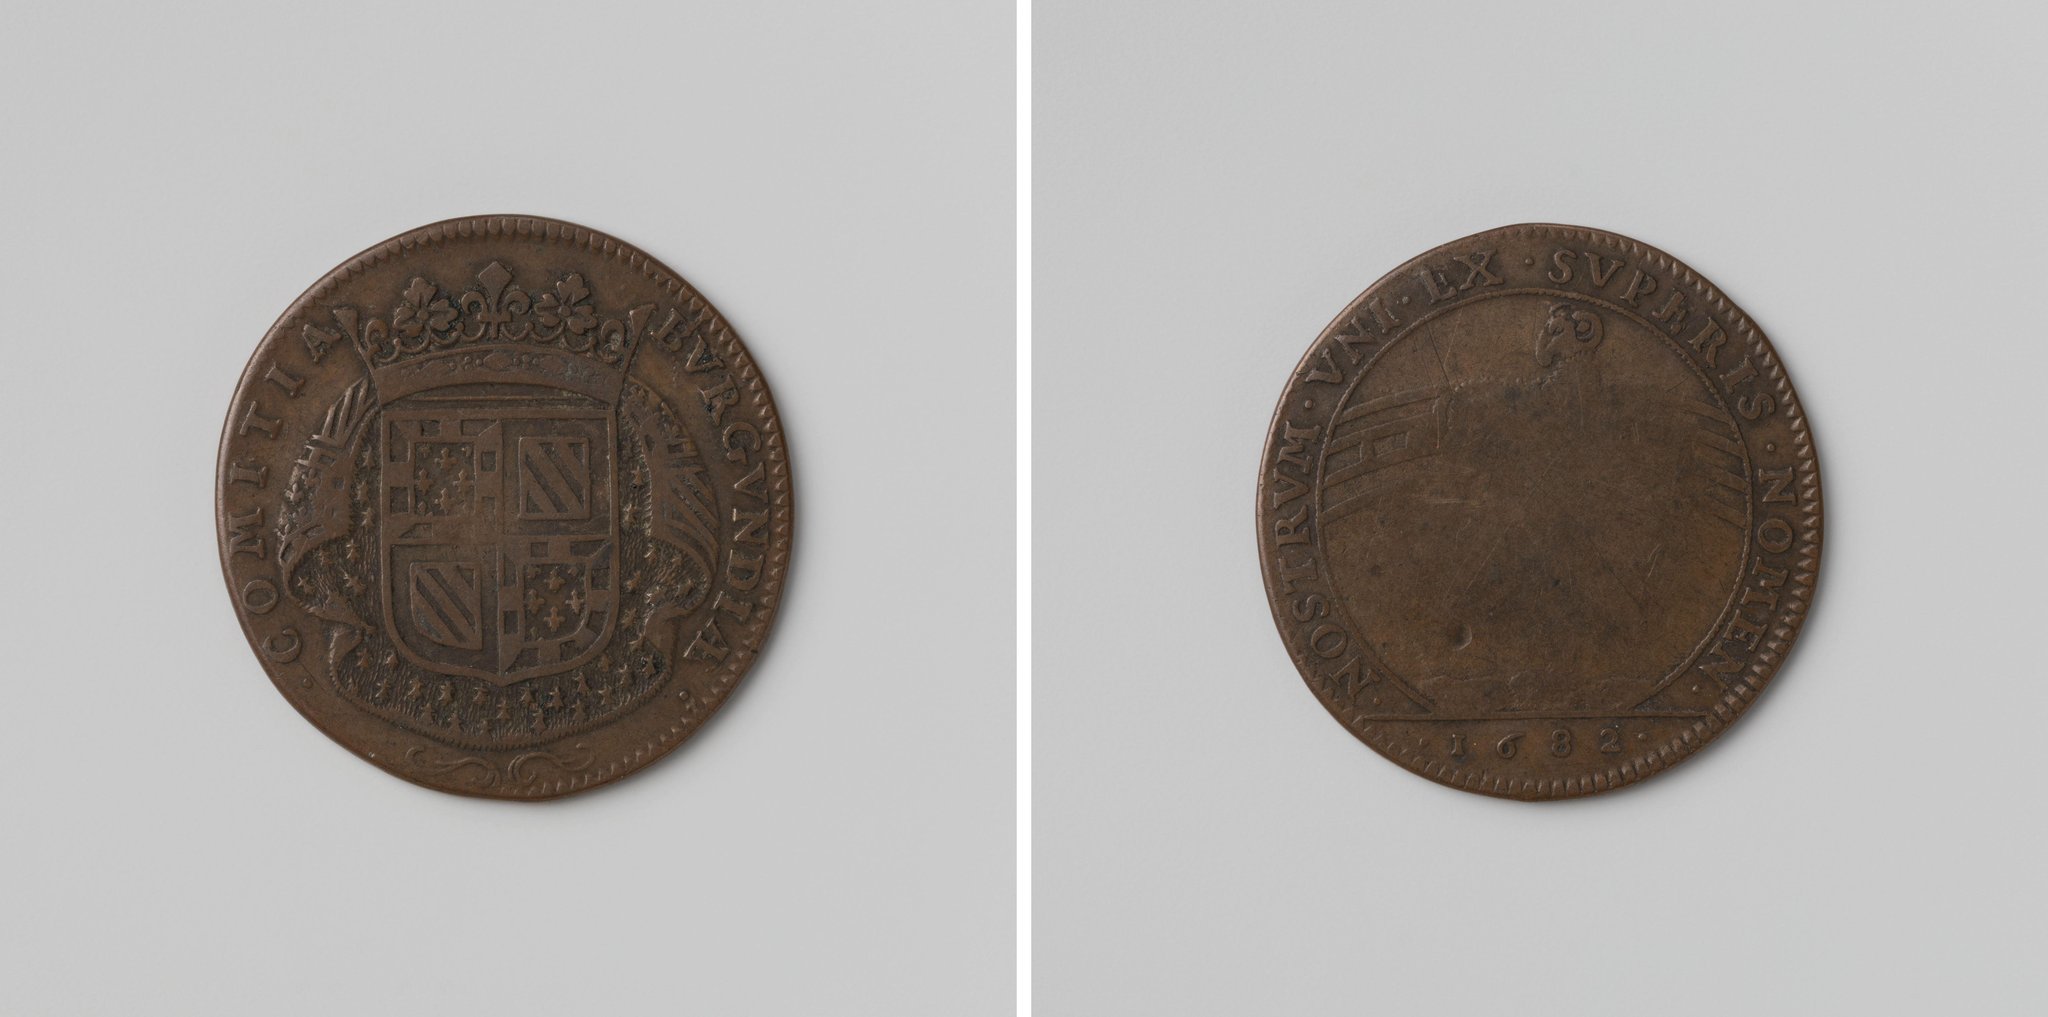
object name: jeton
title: Staten van Bourgondie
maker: Anonymous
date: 1682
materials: copper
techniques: striking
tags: staten van bourgondië, bourgondië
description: Koperen penning. Voorzijde: gekroond wapenschild op hermelijnen mantel binnen omschrift. Keerzijde: dierenriem in teken van ram binnen omschrift; afsnede: jaartal